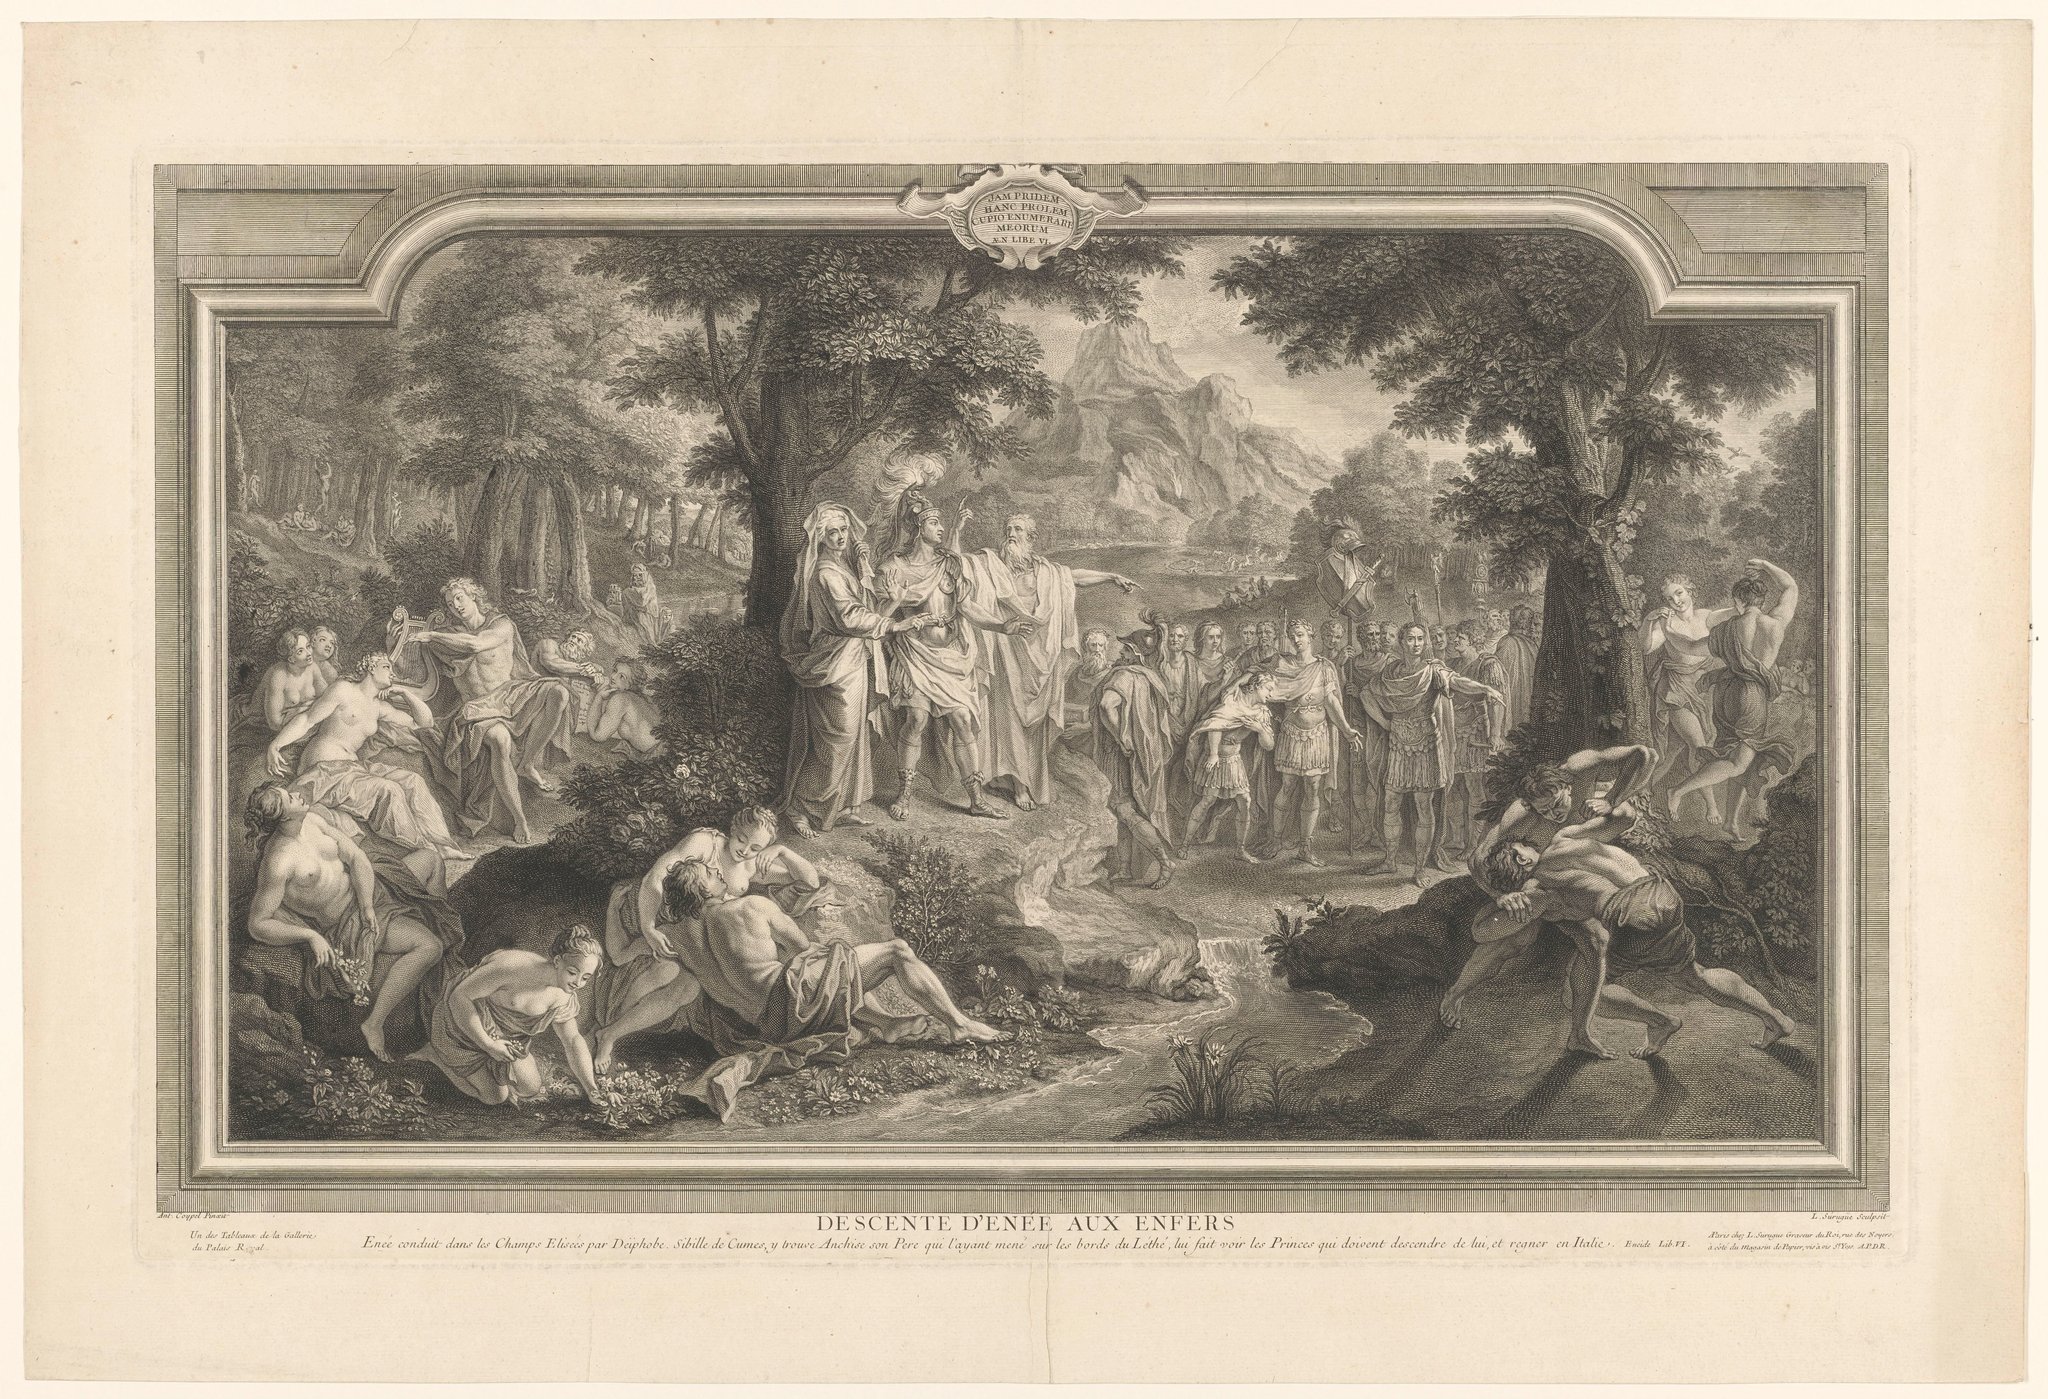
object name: print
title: Descente d'Enée aux enfers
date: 1696-1762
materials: paper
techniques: engraving, etching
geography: france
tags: aeneas, guided by the sibyl, enters the underworld through the cave of avernus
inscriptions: collector's mark: Lugt 2228